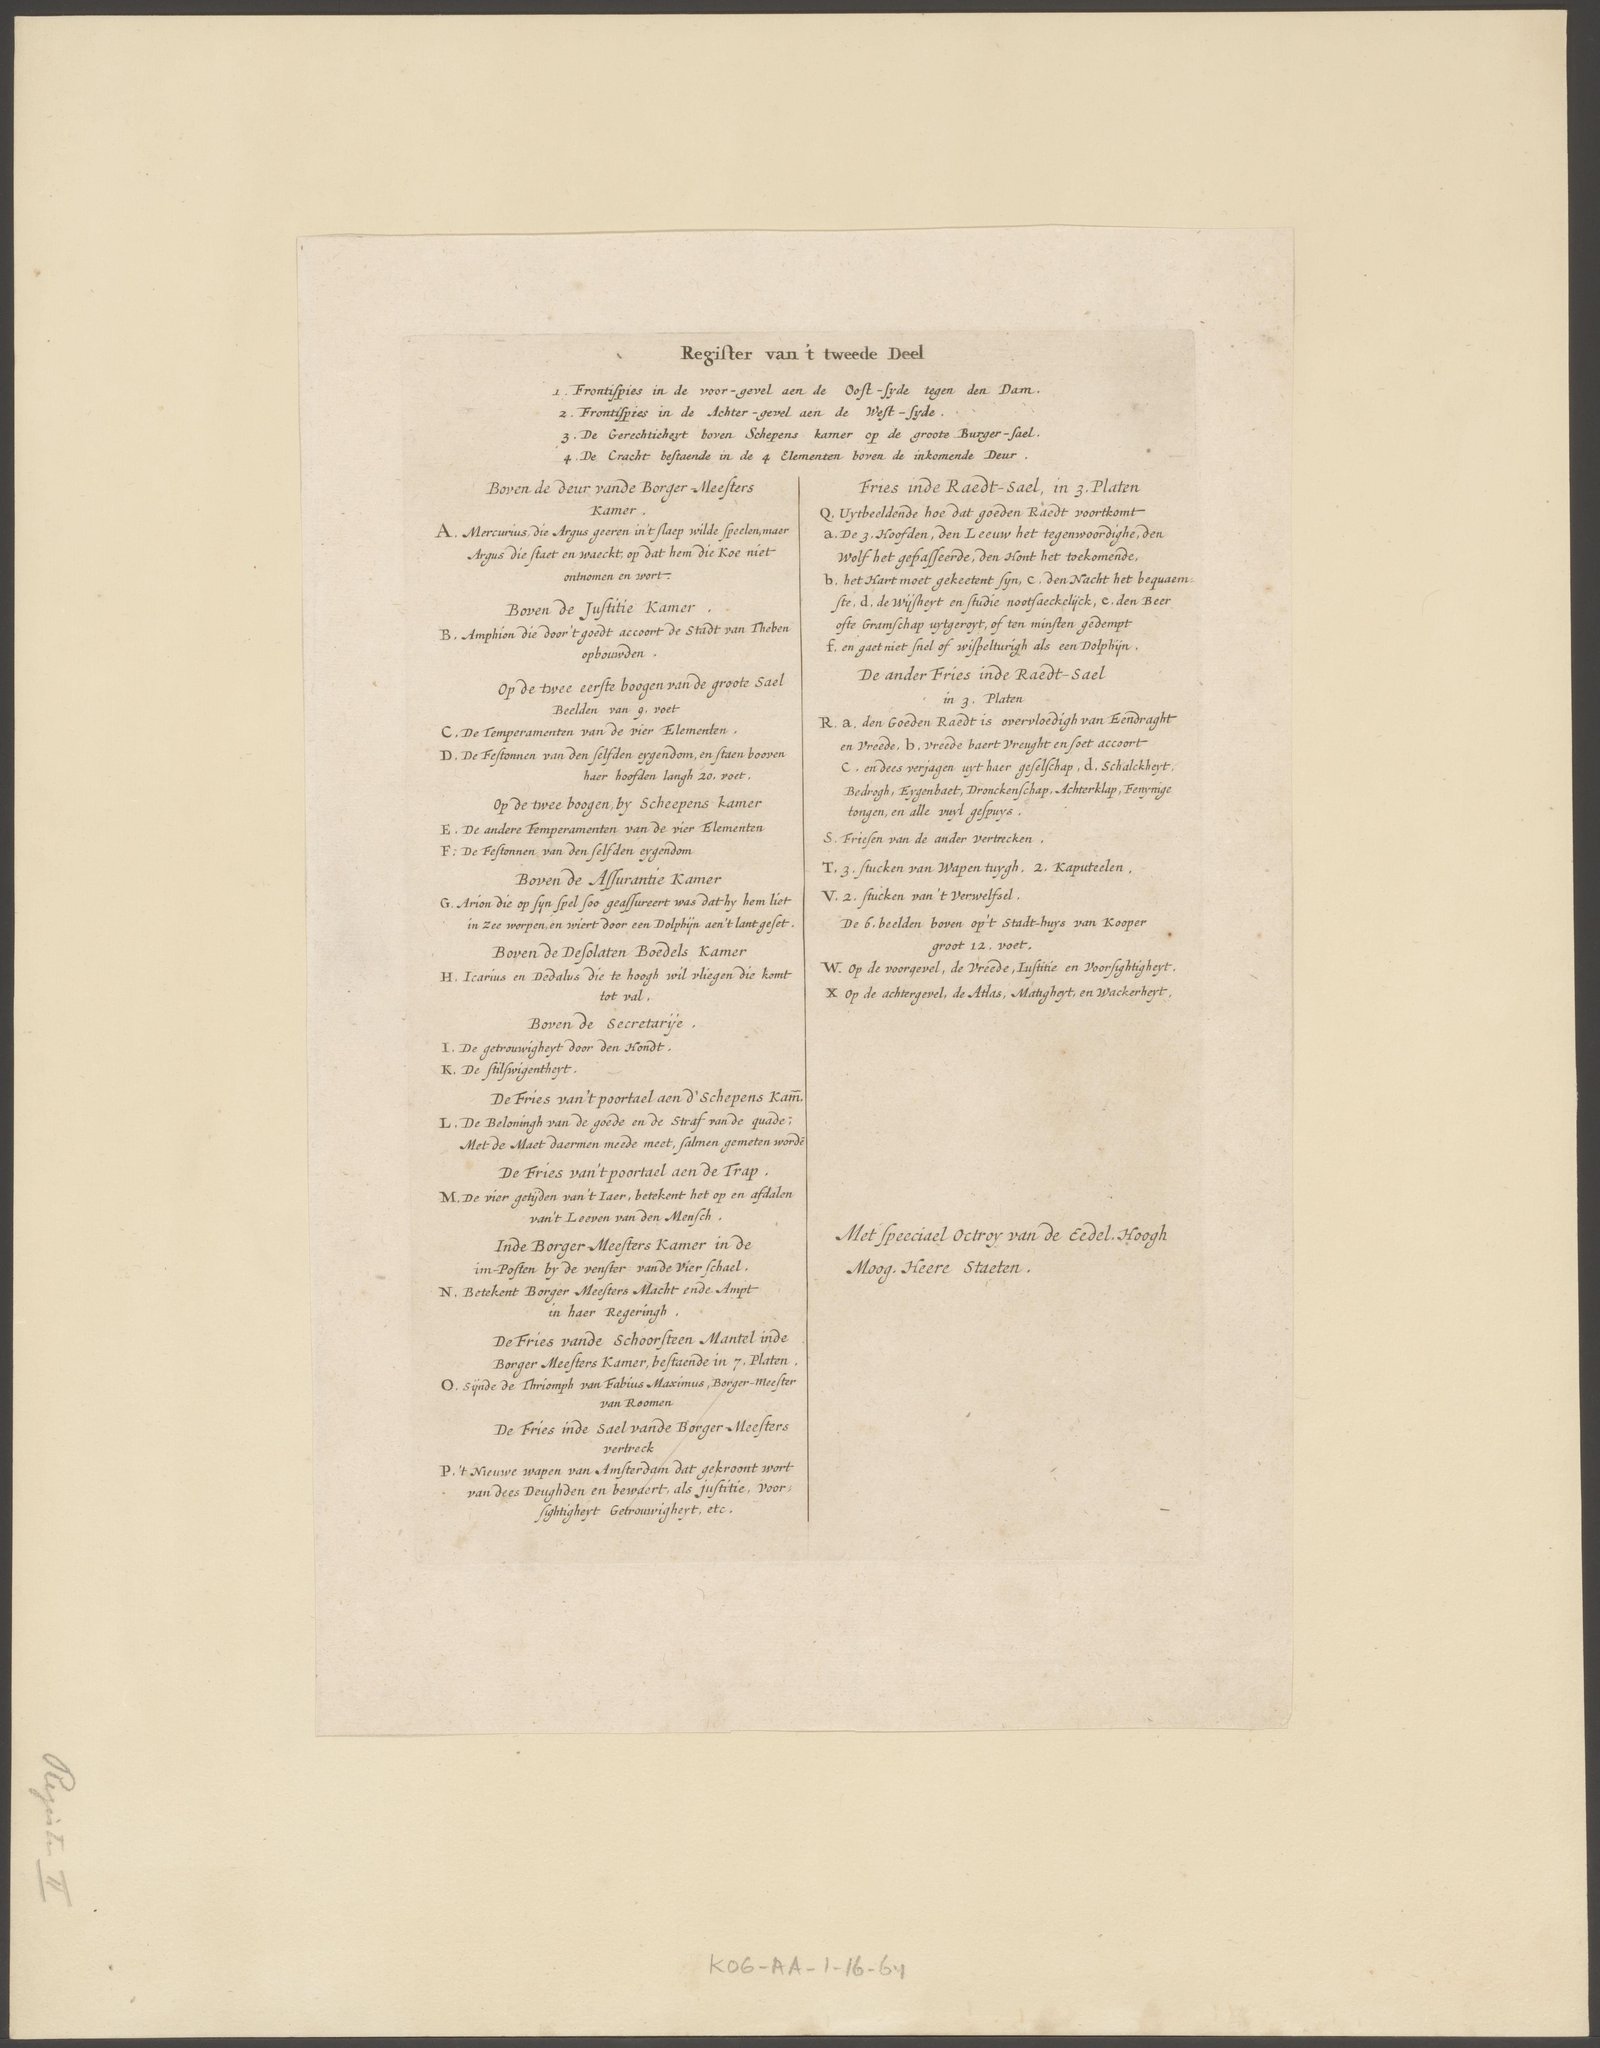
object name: print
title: Register van 't tweede Deel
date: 1668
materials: paper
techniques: engraving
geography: amsterdam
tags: townhall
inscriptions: collector's mark: ‘16,64’ Lugt 1641b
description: Prent gebruikt in: Latere staat van prent ook gebruikt in: Secunca pars Praecipuarum effigierum ac ornamentorum amplissime Curiae Amstelrodamensis maiori ex parte in cadido marmore effectorum per Artum Quellinium eiusdem Civitatis Statuarium / Het tweede deel Van de voornaemste Statuen ende Cieraten van 't konst-rijcke Stadt-huys van Amstelredam 'tmeeste in Marmer gemaeckt door Artus Quellinus Beelthouwer der voorseyde Stadt. Amsterdam: Frederik de Wit, 1668. Zie RP-P-AO-22-2-2 voor bijhorend register. Zie RP-P-AO-22-2A, RP-P-AO-22-2B, RP-P-AO-22-2C-1, RP-P-AO-22-2C-2, RP-P-AO-22-2C-3, RP-P-AO-22-2C-4, RP-P-AO-22-2D-1, RP-P-AO-22-2D-2, RP-P-AO-22-2D-3, RP-P-AO-22-2E-1, RP-P-AO-22-2E-2, RP-P-AO-22-2E-3, RP-P-AO-22-2E-4, RP-P-AO-22-2F-1, RP-P-AO-22-2F-2, RP-P-AO-22-2F-3, RP-P-AO-22-2G, RP-P-AO-22-2H, RP-P-AO-22-2I, RP-P-AO-22-2K, RP-P-AO-22-2L, RP-P-AO-22-2M, RP-P-AO-22-2N, RP-P-AO-22-2O-1, RP-P-AO-22-2O-2, RP-P-AO-22-2O-3, RP-P-AO-22-2O-4, RP-P-AO-22-2O-5, RP-P-AO-22-2O-6, RP-P-AO-22-2O-7, RP-P-AO-22-2P-1, RP-P-AO-22-2P-2, RP-P-AO-22-2Q-1, RP-P-AO-22-2Q-2, RP-P-AO-22-2Q-3, RP-P-AO-22-2R-1, RP-P-AO-22-2R-2, RP-P-AO-22-2R-3, RP-P-AO-22-2S, RP-P-AO-22-2T-1, RP-P-AO-22-2T-2, RP-P-AO-22-2T-3, RP-P-AO-22-2T-4, RP-P-AO-22-2V-1, RP-P-AO-22-2V-2, RP-P-AO-22-2W-1, RP-P-AO-22-2W-2, RP-P-AO-22-2X-1, RP-P-AO-22-2X-2 en RP-P-AO-22-2X-3 voor prenten uit deze publicatie. Eerdere staat van prent ook gebruikt in: Secunca pars Praecipuarum effigierum ac ornamentorum amplissime Curiae Amstelrodamensis maiori ex parte in cadido marmore effectorum per Artum Quellinium eiusdem Civitatis Statuarium / Het tweede deel Van de voornaemste Statuen ende Cieraten van 't konst-rijcke Stadt-huys van Amstelredam 'tmeeste in Marmer gemaeckt door Artus Quellinus Beelthouwer der voorseyde Stadt. Amsterdam: Artus Quellinus (I), 1663. Zie RP-P-AO-22-1-2 voor register van eerste deel.